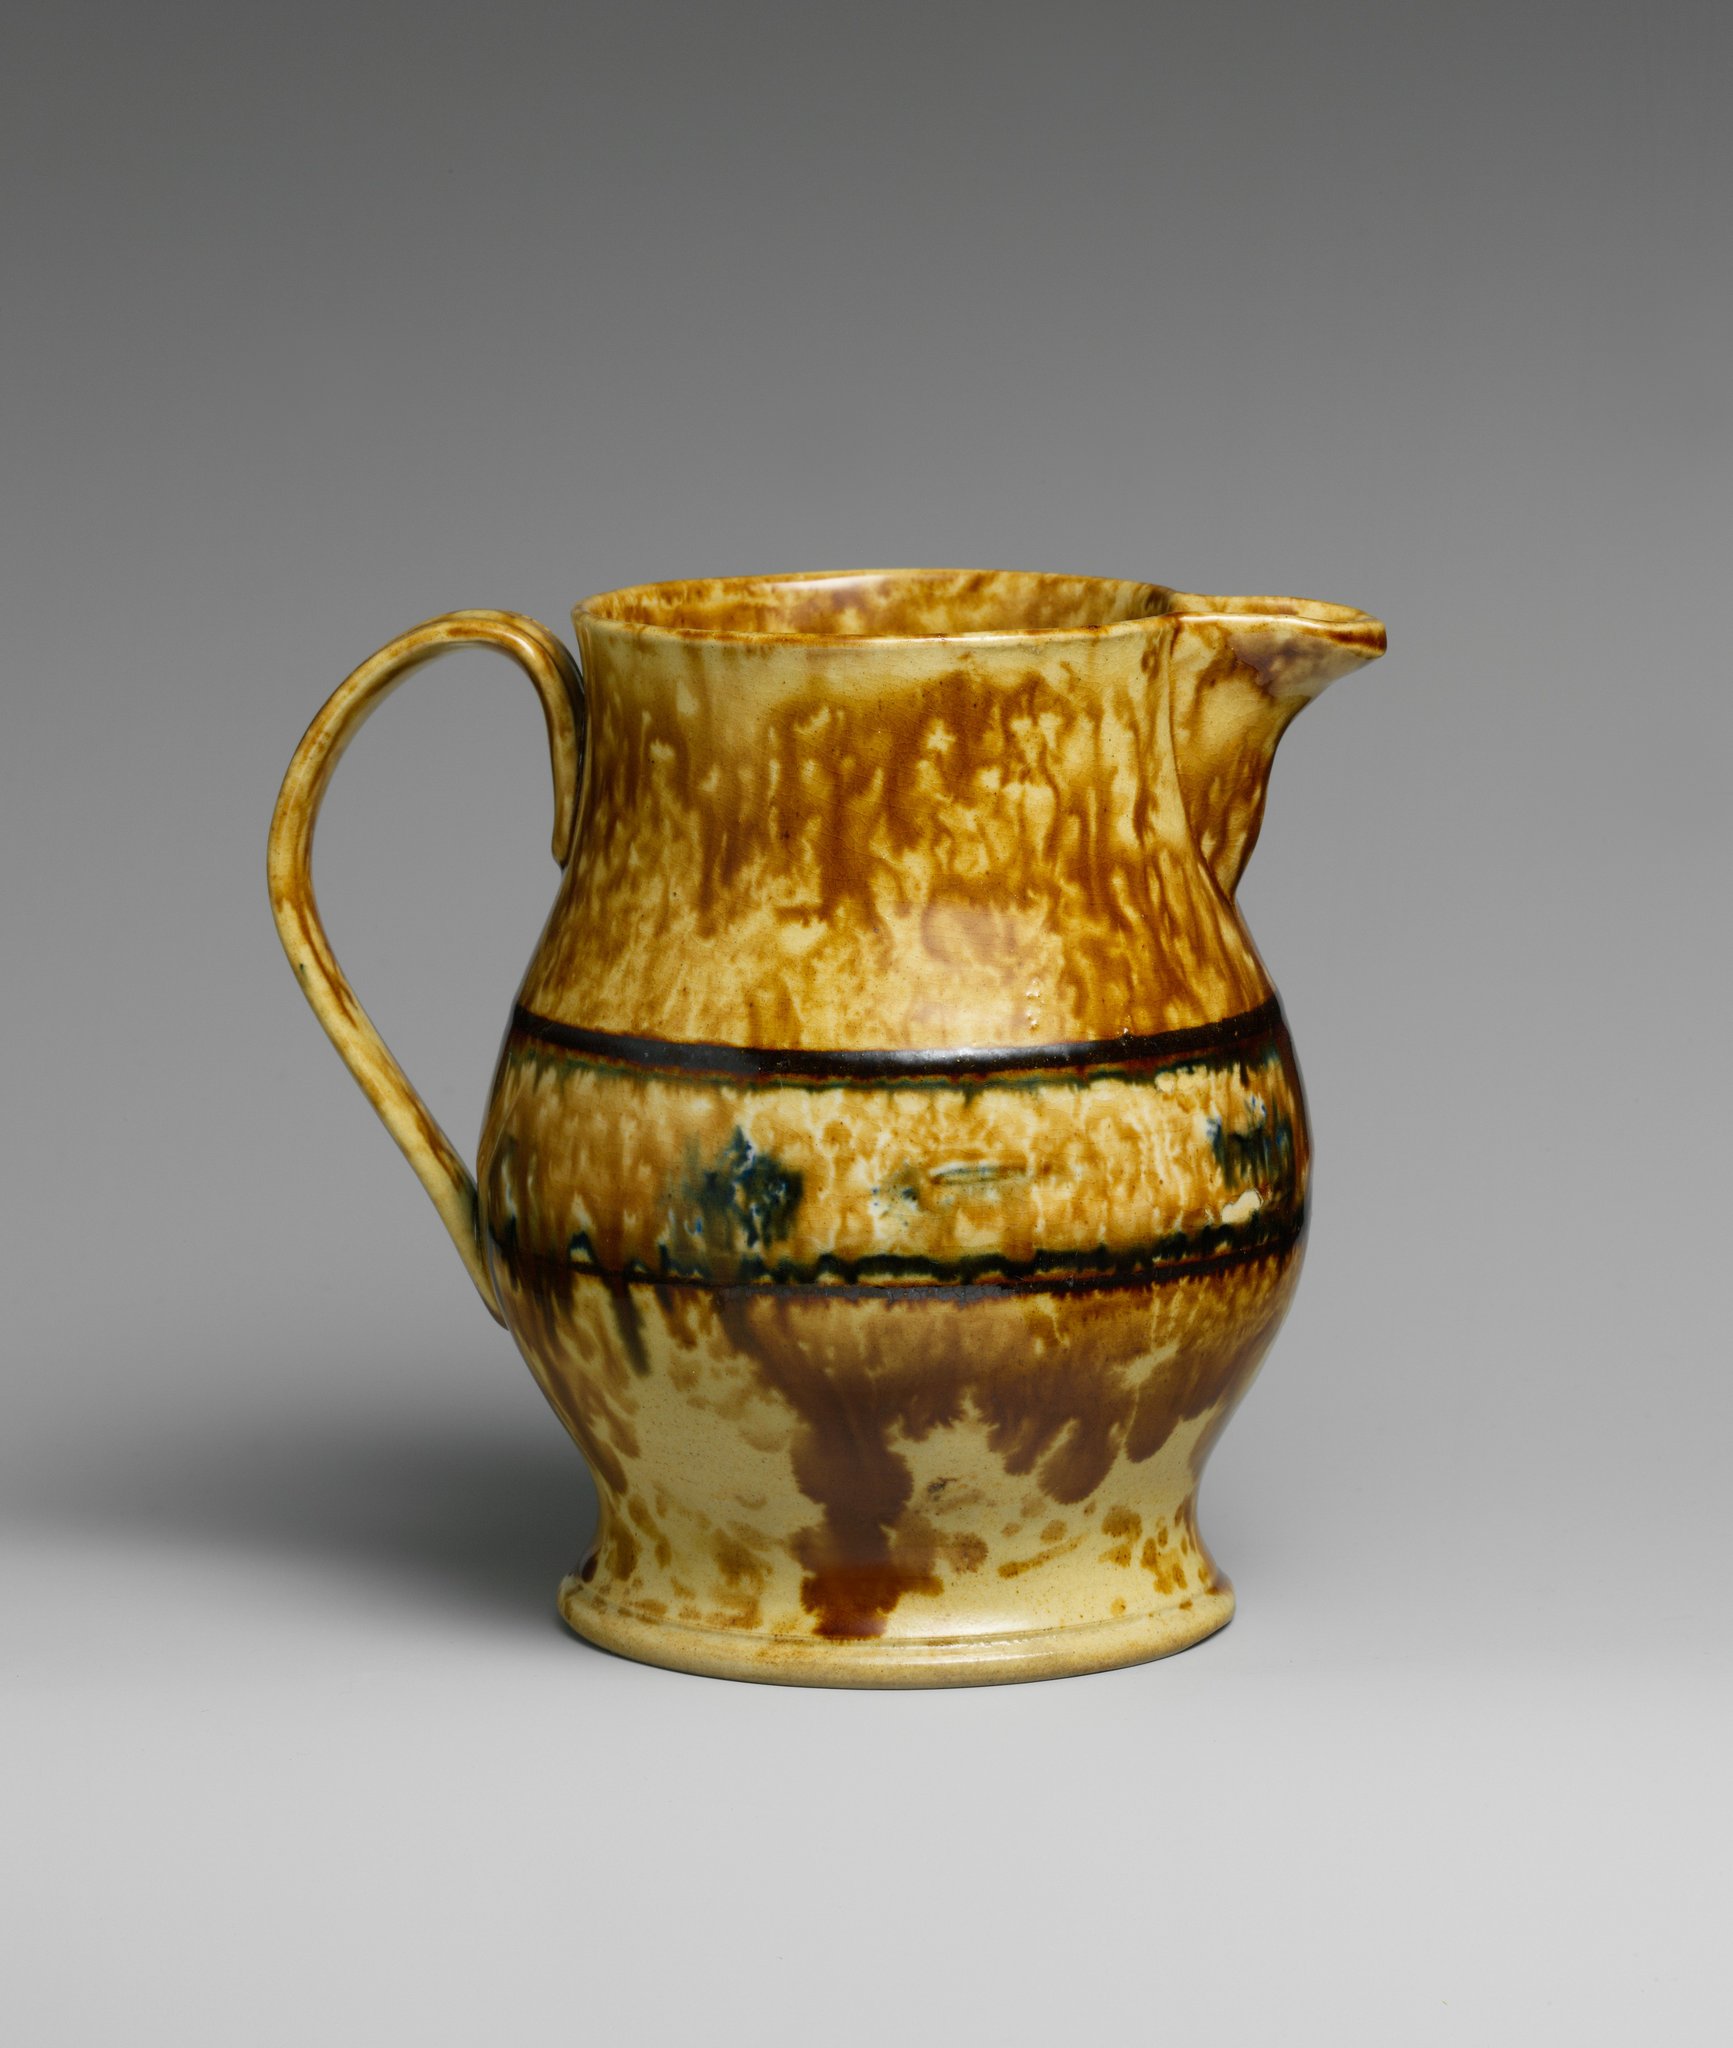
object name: pitcher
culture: american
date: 1800-1900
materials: earthenware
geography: united states